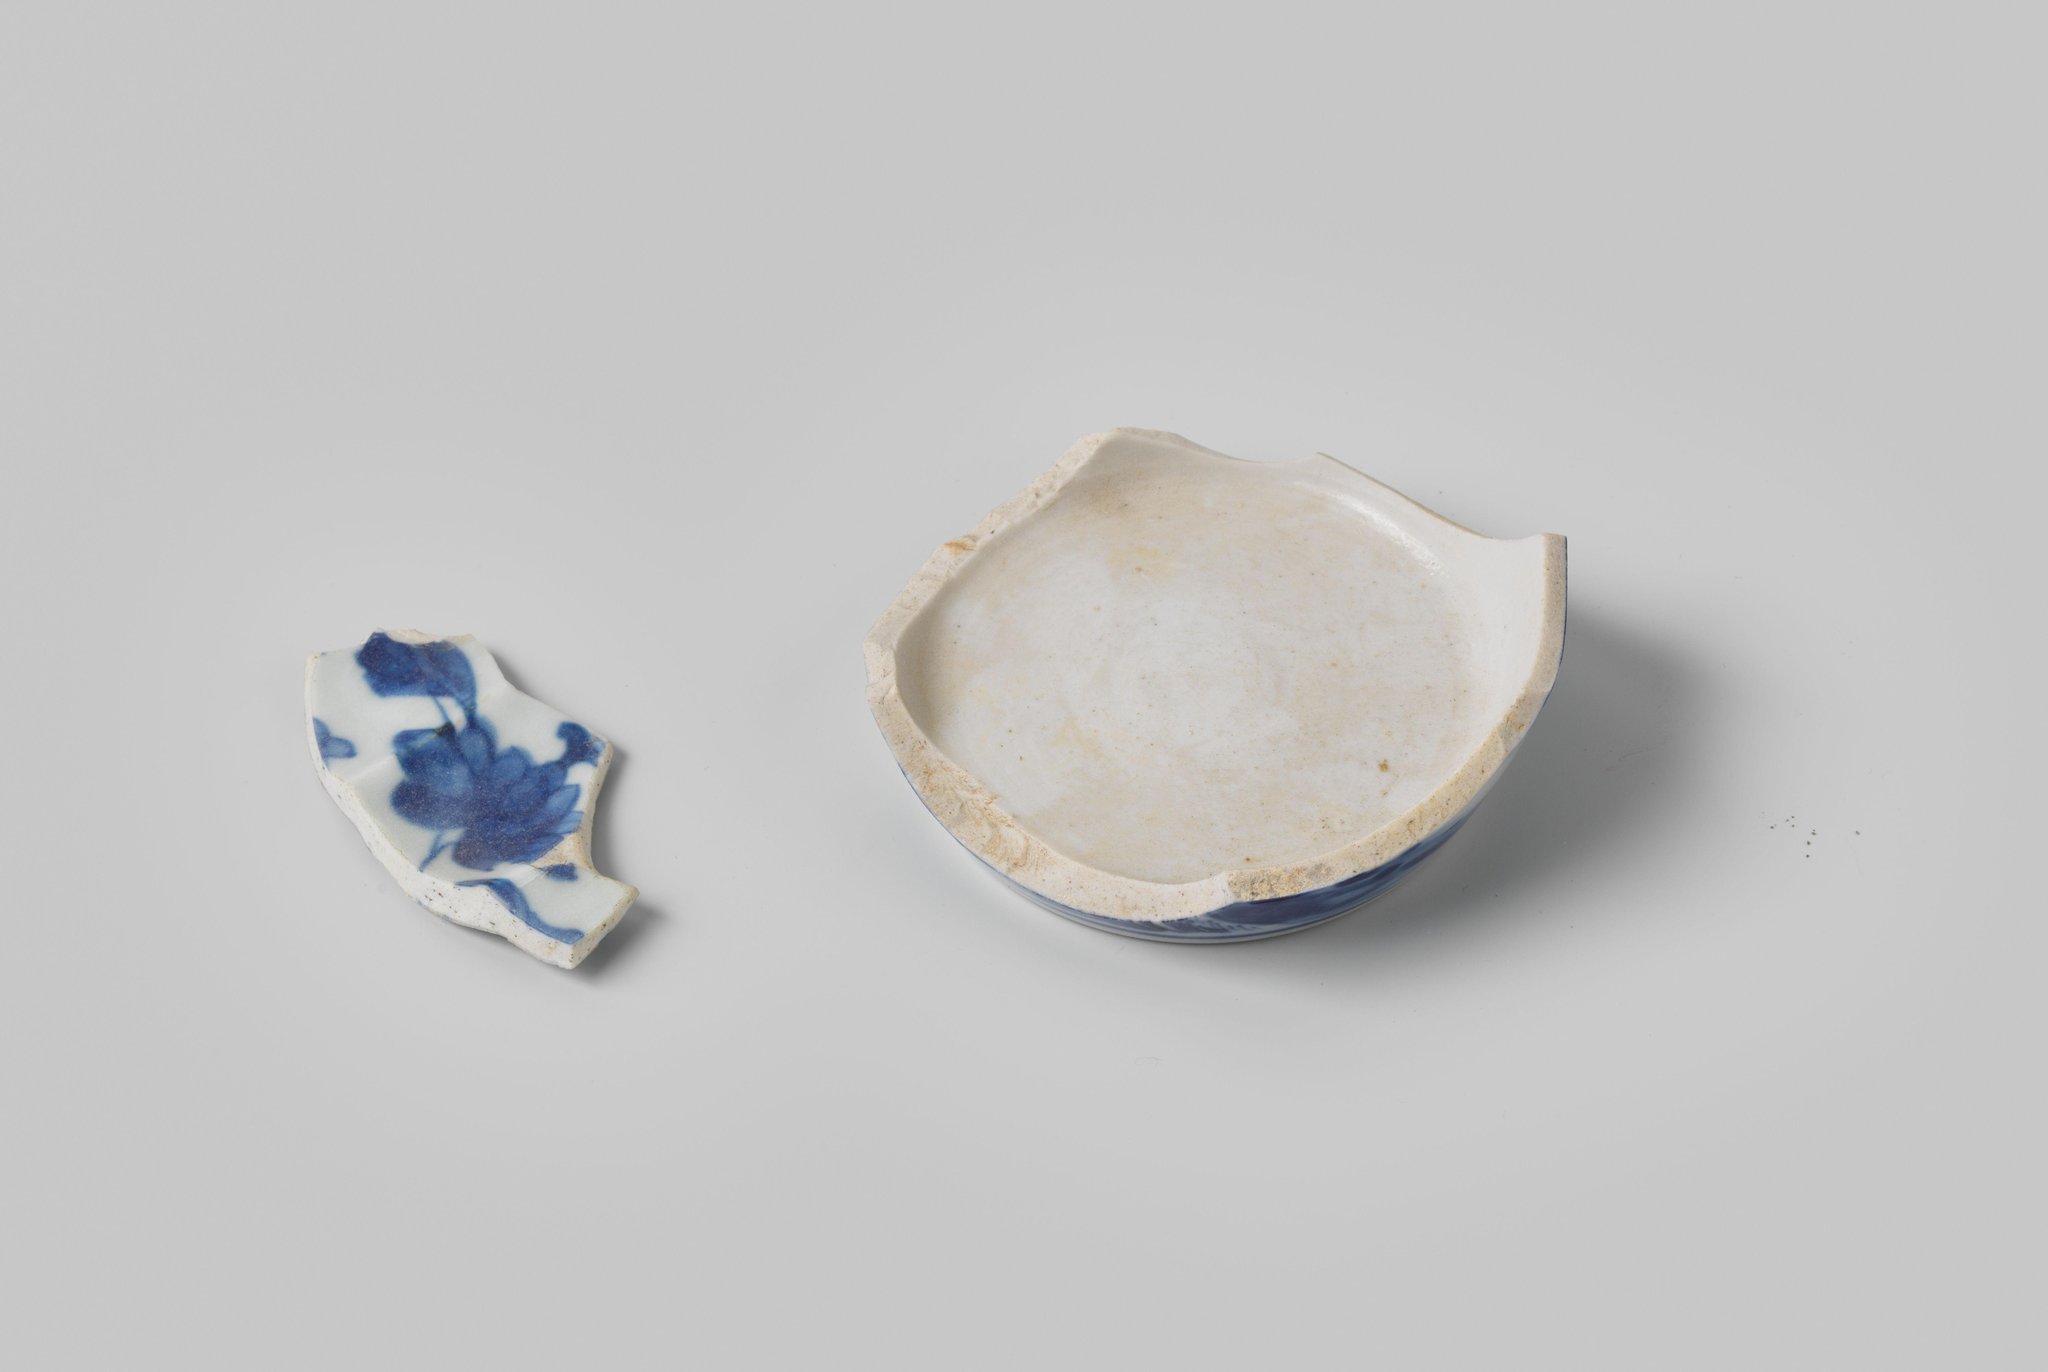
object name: cup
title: Twee scherven van een kom, gevonden bij V.O.C.-schip Witte Leeuw, mogelijk afkomstig van Zeelelie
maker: Anonymous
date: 1775-1800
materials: porcelain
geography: jingdezhen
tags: verenigde oostindische compagnie, sint-helena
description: A mug. Part of a base and side of a mug. There are three joints of ears, decorated with twigs in relief, on the sides. A grey-white body, with deep purple blue painting on the outside and on the relief twigs. The exterior decorated with a river landscape with a boat and a willow behind a fence, trees and a building. Two concentric lines above the base. Bluish white translucent glaze.